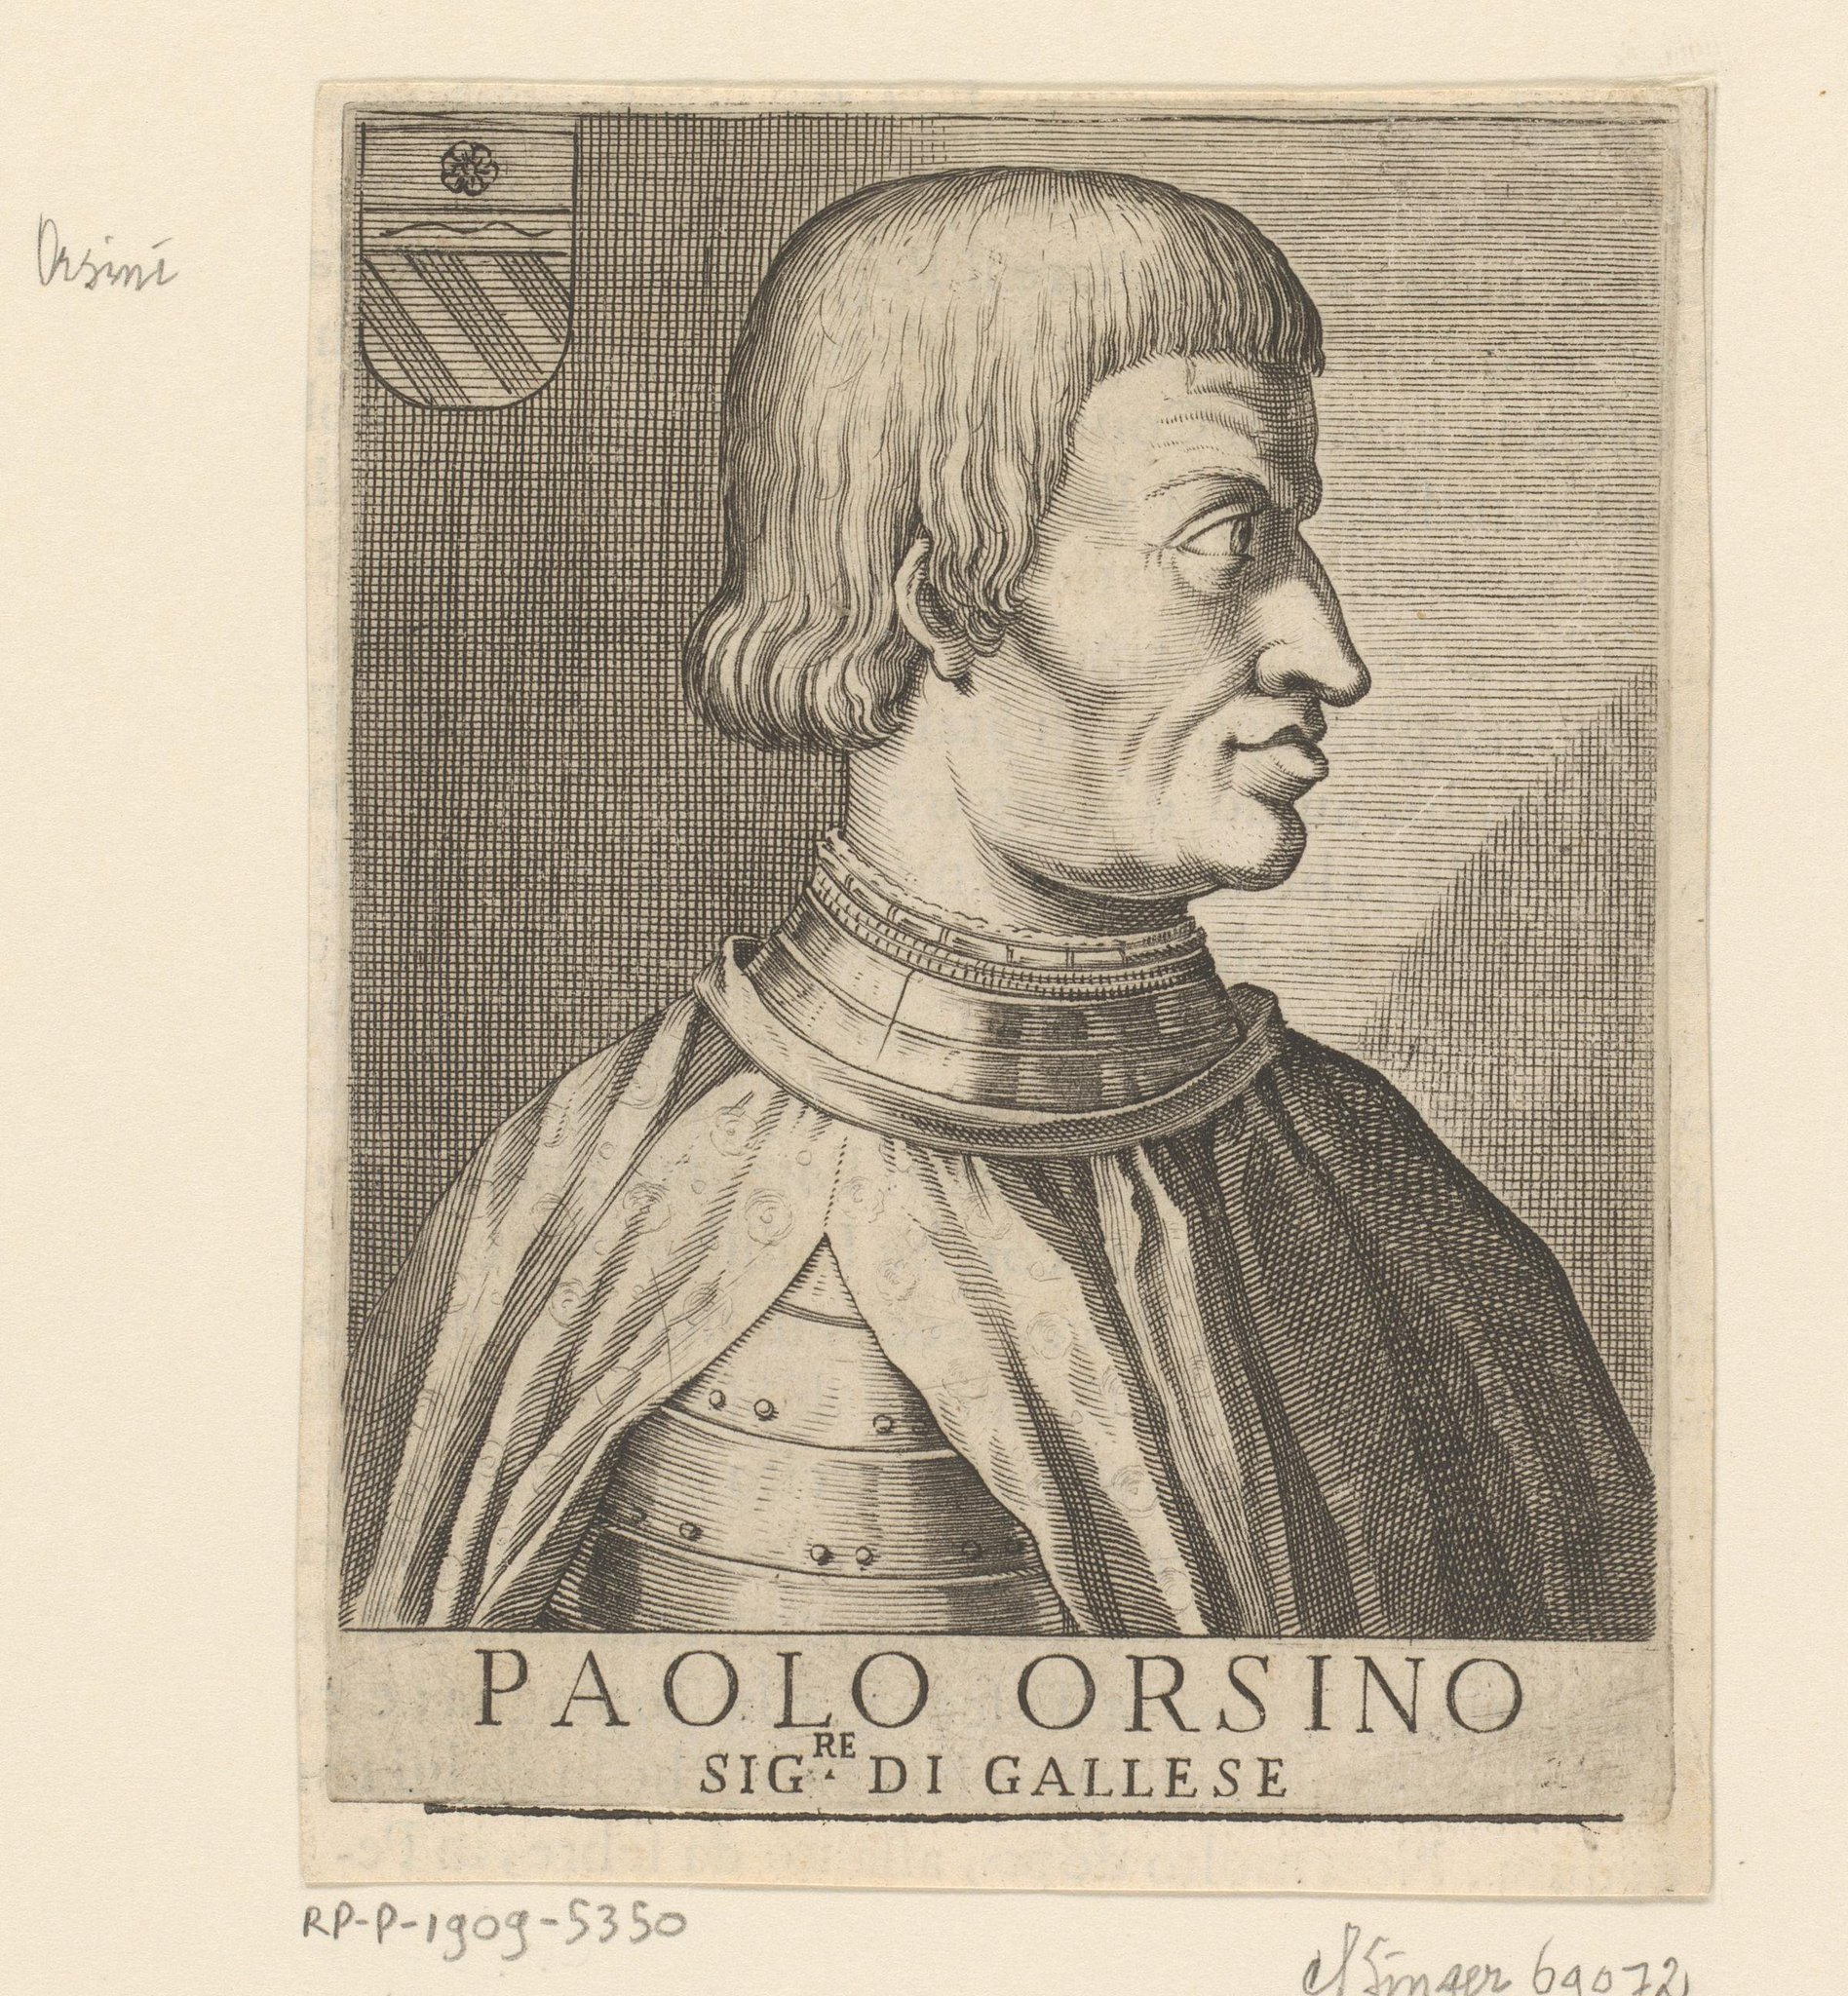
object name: print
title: Portret van legeraanvoerder Paolo Orsini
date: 1546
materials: paper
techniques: engraving, letterpress printing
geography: rome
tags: commander-in-chief, general, marshal, historical persons, armorial bearing, heraldry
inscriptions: collector's mark: Lugt 2228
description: Prent uit: Ritratti et elogii di capitani Illustri. Che ne'secoli moderni hanno gloriosamente guerreggiato. Rome: Filippo de'Rossi en Vitale Mascardi, 1646, p. 80. Eerdere staat van prent in ieder geval ook gebruikt in: Ritratti et elogii di capitani Illustri. Rome: Pompilio Totti en Andrea Fei, 1635.